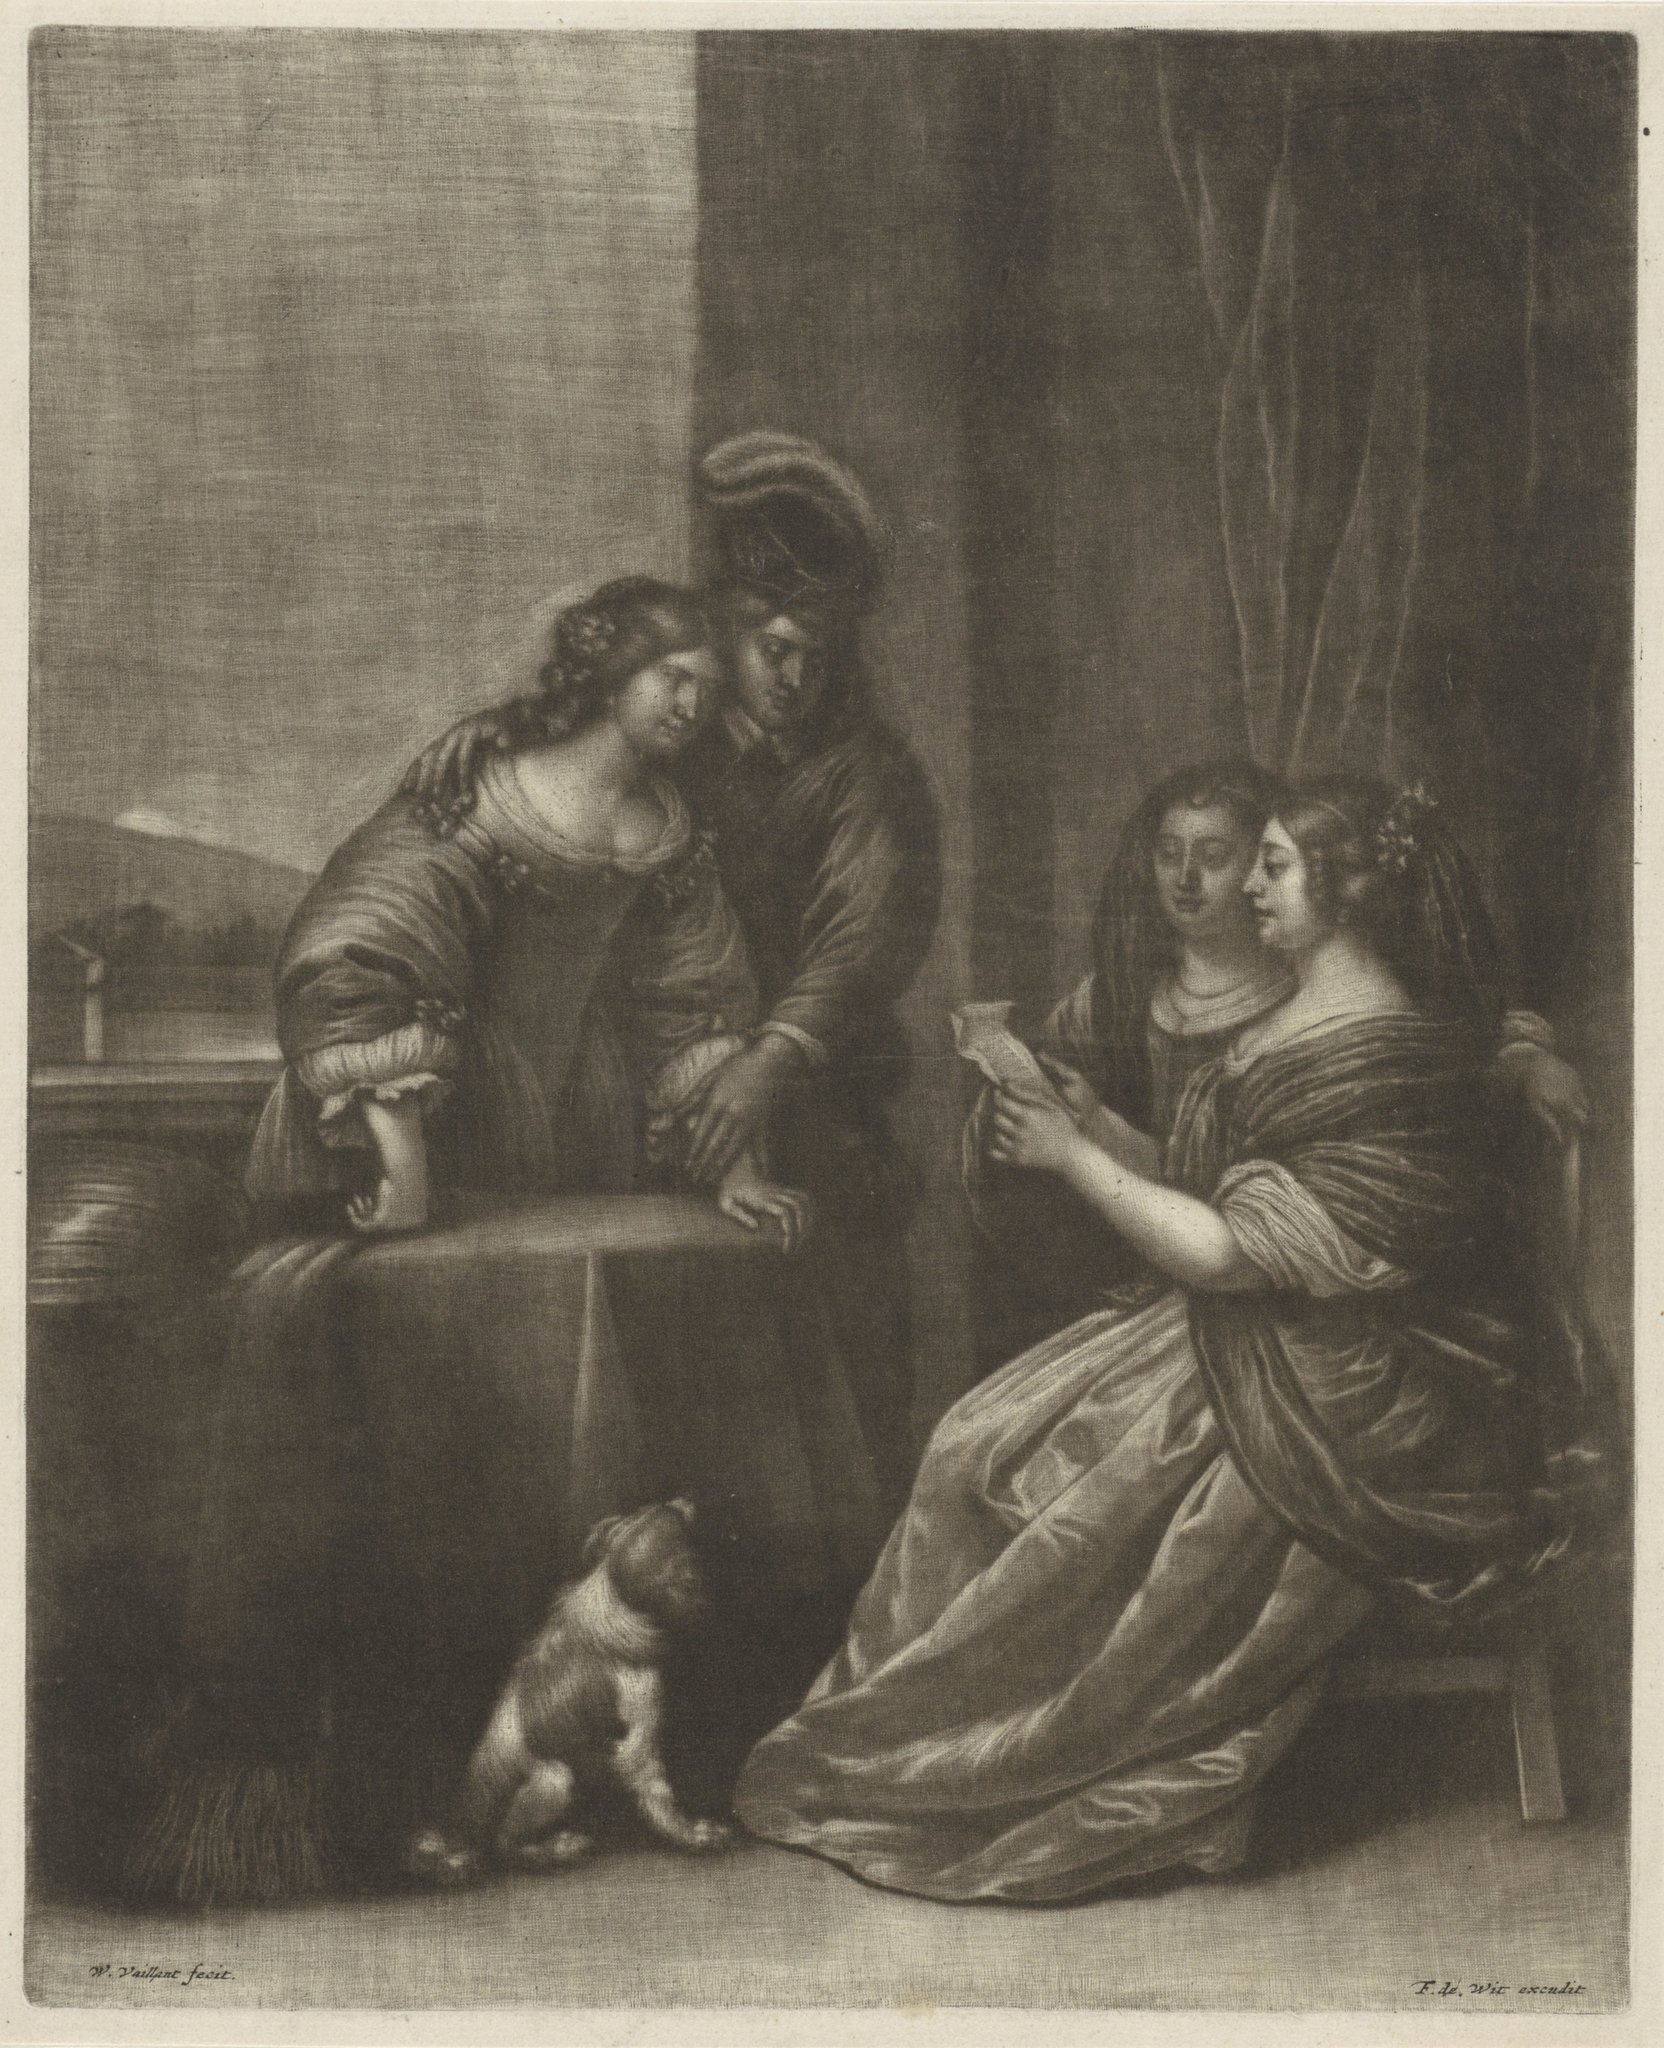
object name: print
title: Brieflezende vrouw op een terras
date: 1658-1706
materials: paper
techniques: mezzotint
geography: amsterdam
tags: reading, landscapes, letter, envelope, dog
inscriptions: collector's mark: Lugt 2228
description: Op een terras leest een vrouw een brief voor aan twee andere vrouwen en een man. Voor haar zit een hondje. Op de achtergrond een glooiend landschap.